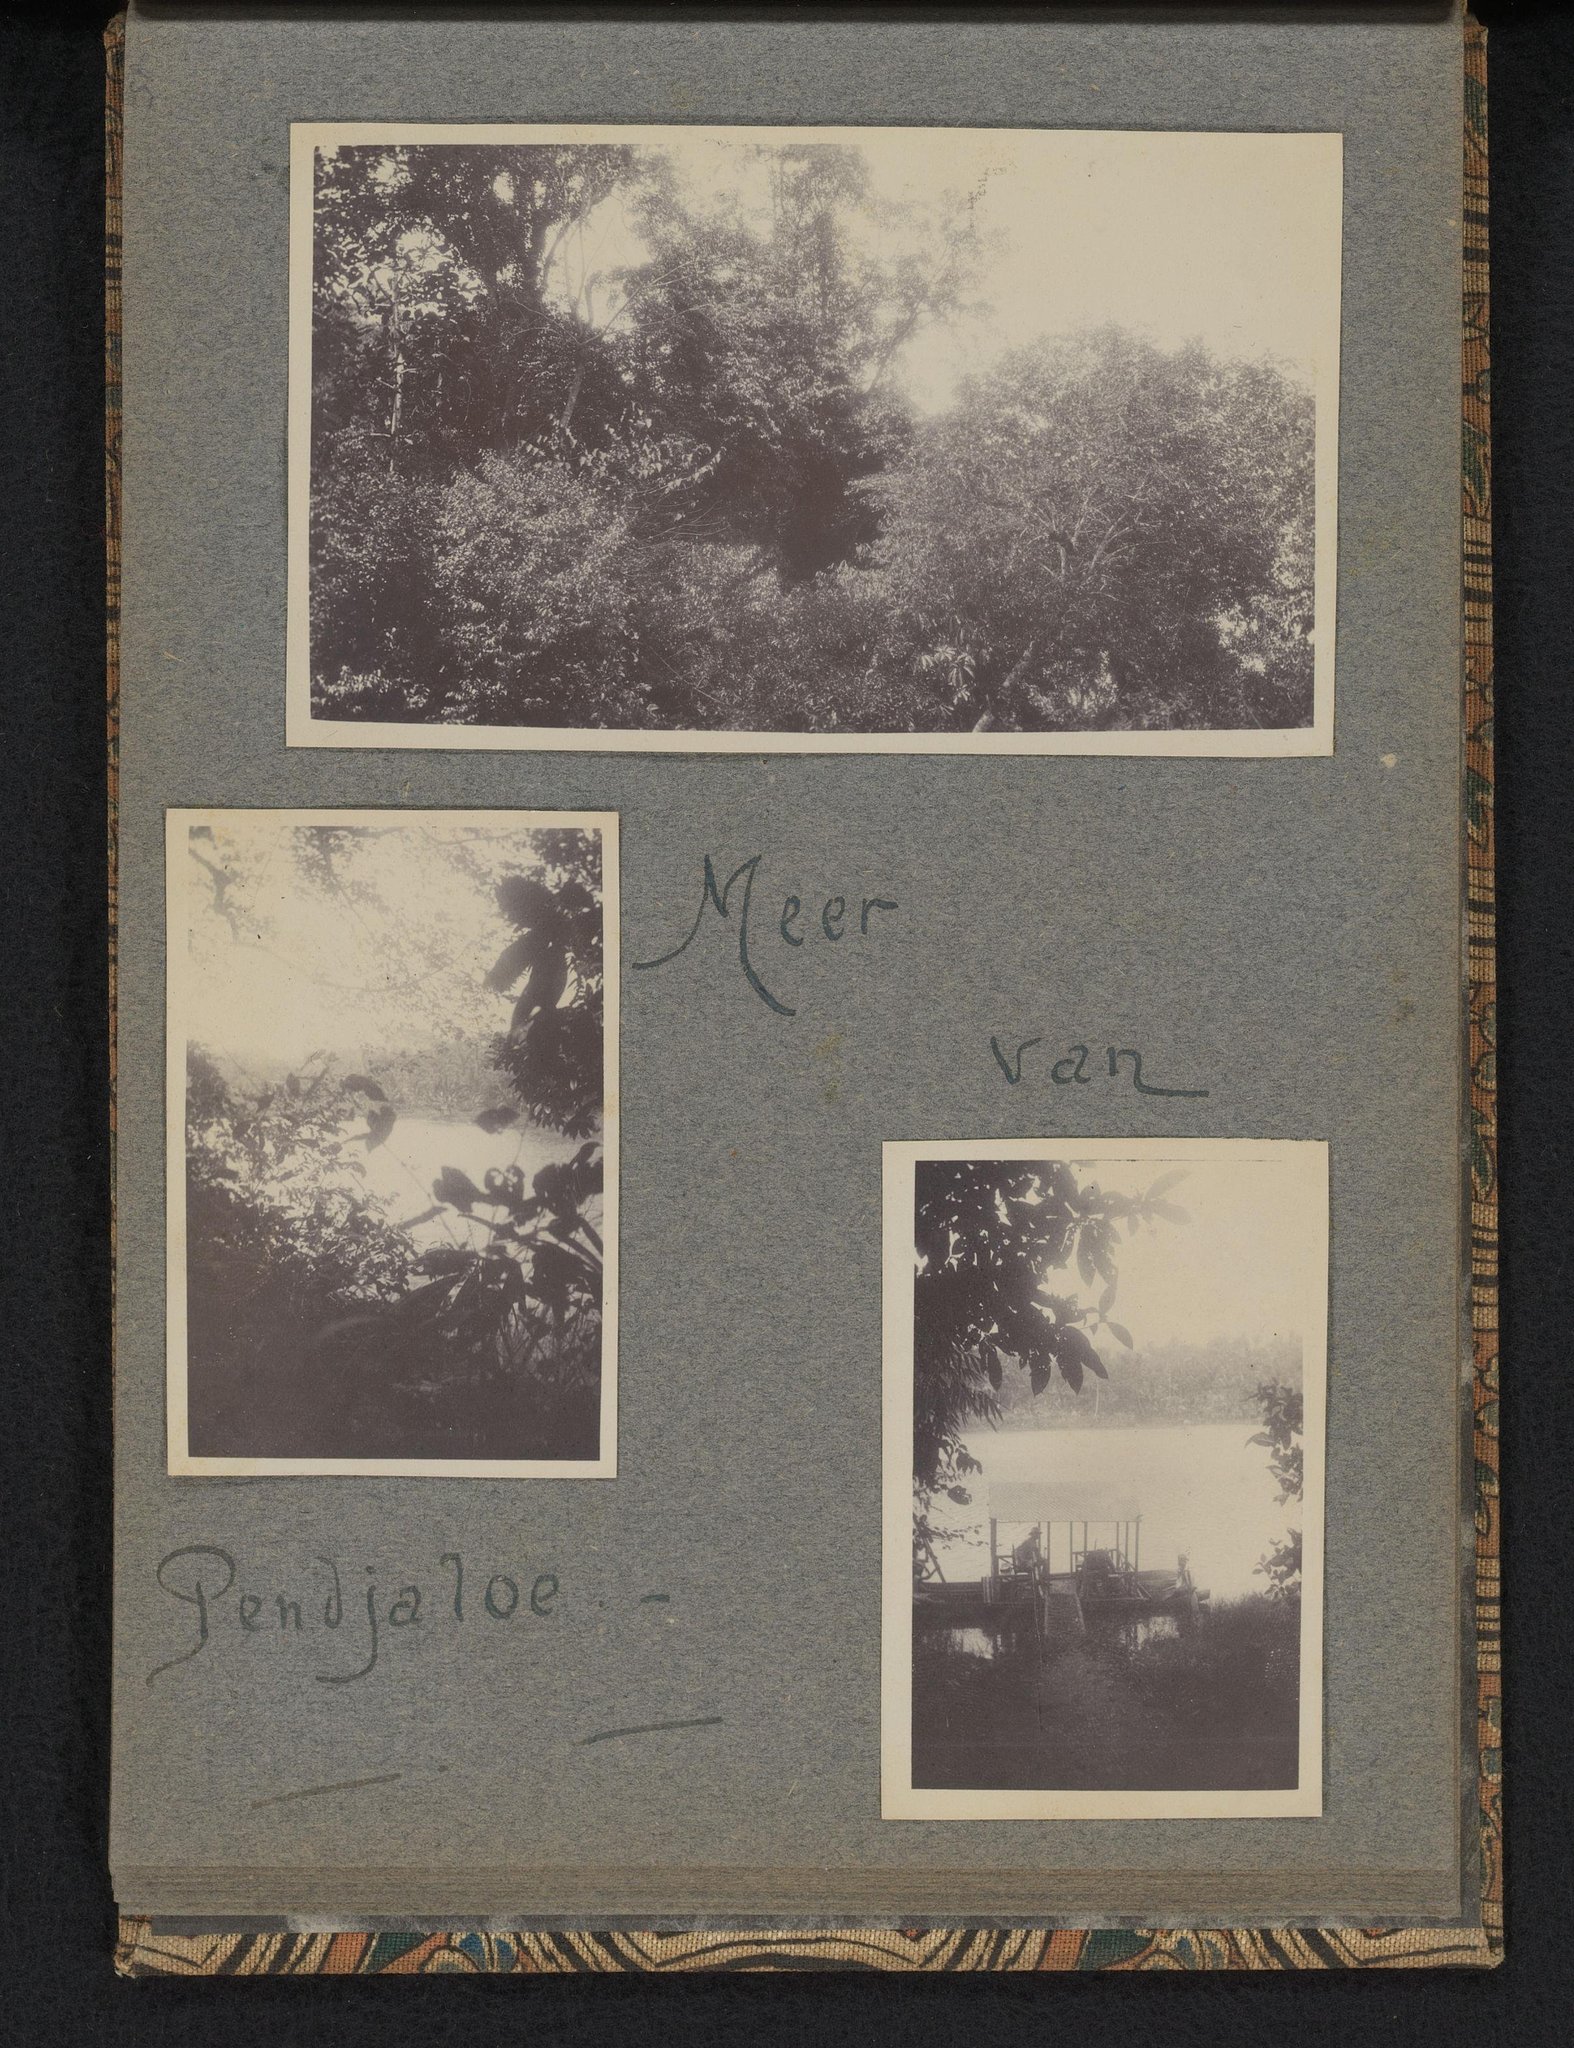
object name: album leaf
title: Gezichten op het Pendjaloemeer op West-Java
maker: karel frederik van den berg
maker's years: 1873-1948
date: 1921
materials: paper, cardboard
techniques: gelatin silver print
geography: west java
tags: coast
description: Deze foto's zijn onderdeel van een album.